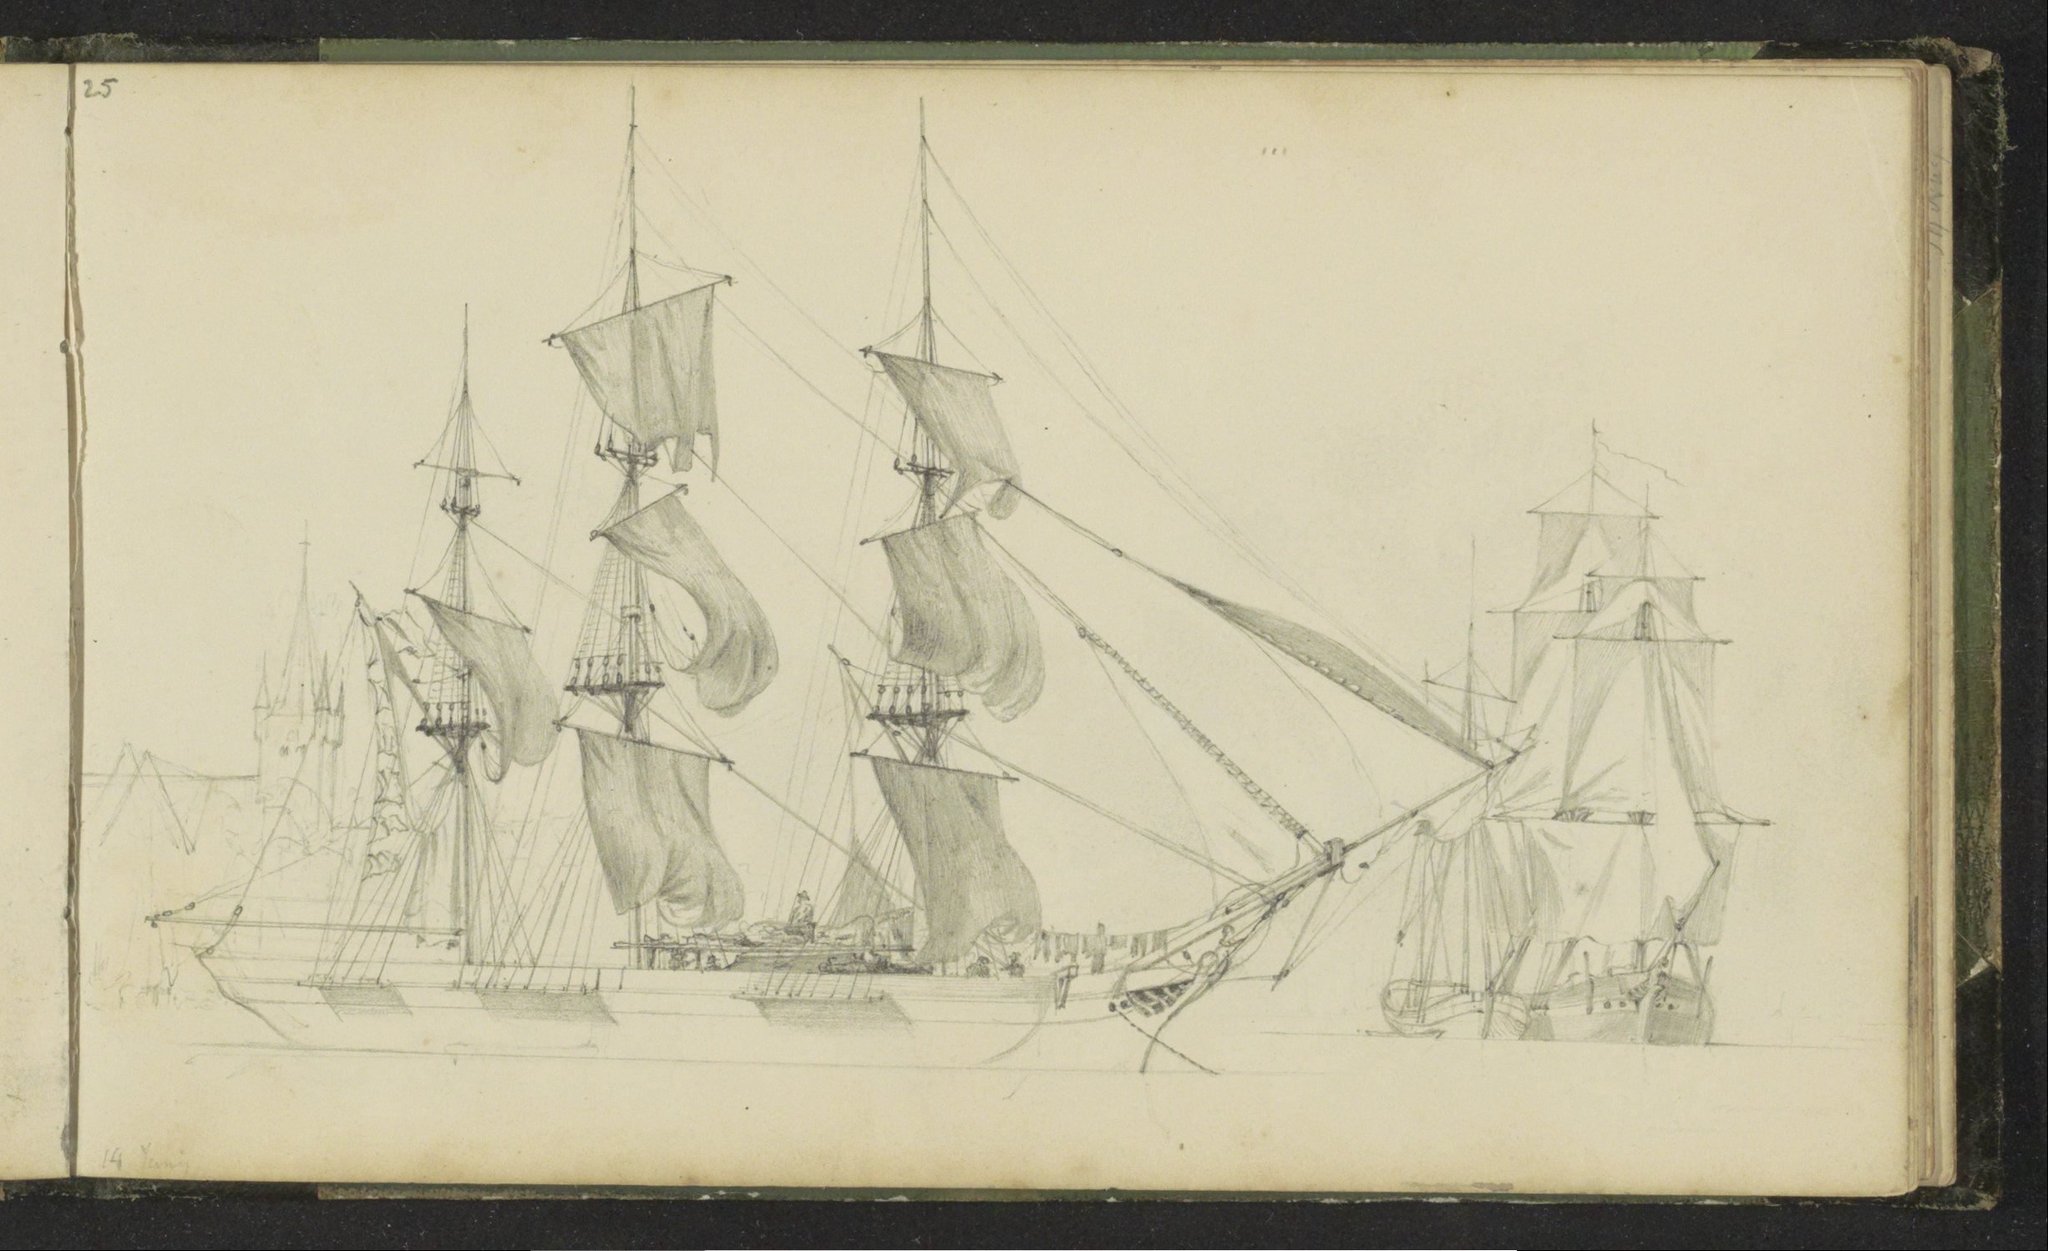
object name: sketchbook leaf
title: Afgemeerde driemaster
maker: hendrik abraham klinkhamer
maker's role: draughtsman, painter, print maker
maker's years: 1810-1872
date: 1806-1843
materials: paper, pencil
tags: city-view, and landscape with man-made constructions, sailing-ship, sailing-boat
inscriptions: date: ‘14 Junij’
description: Op de achtergrond is een toren, vermoedelijk van een kerk, te zien. Blad 25 recto uit een schetsboek met 40 bladen.